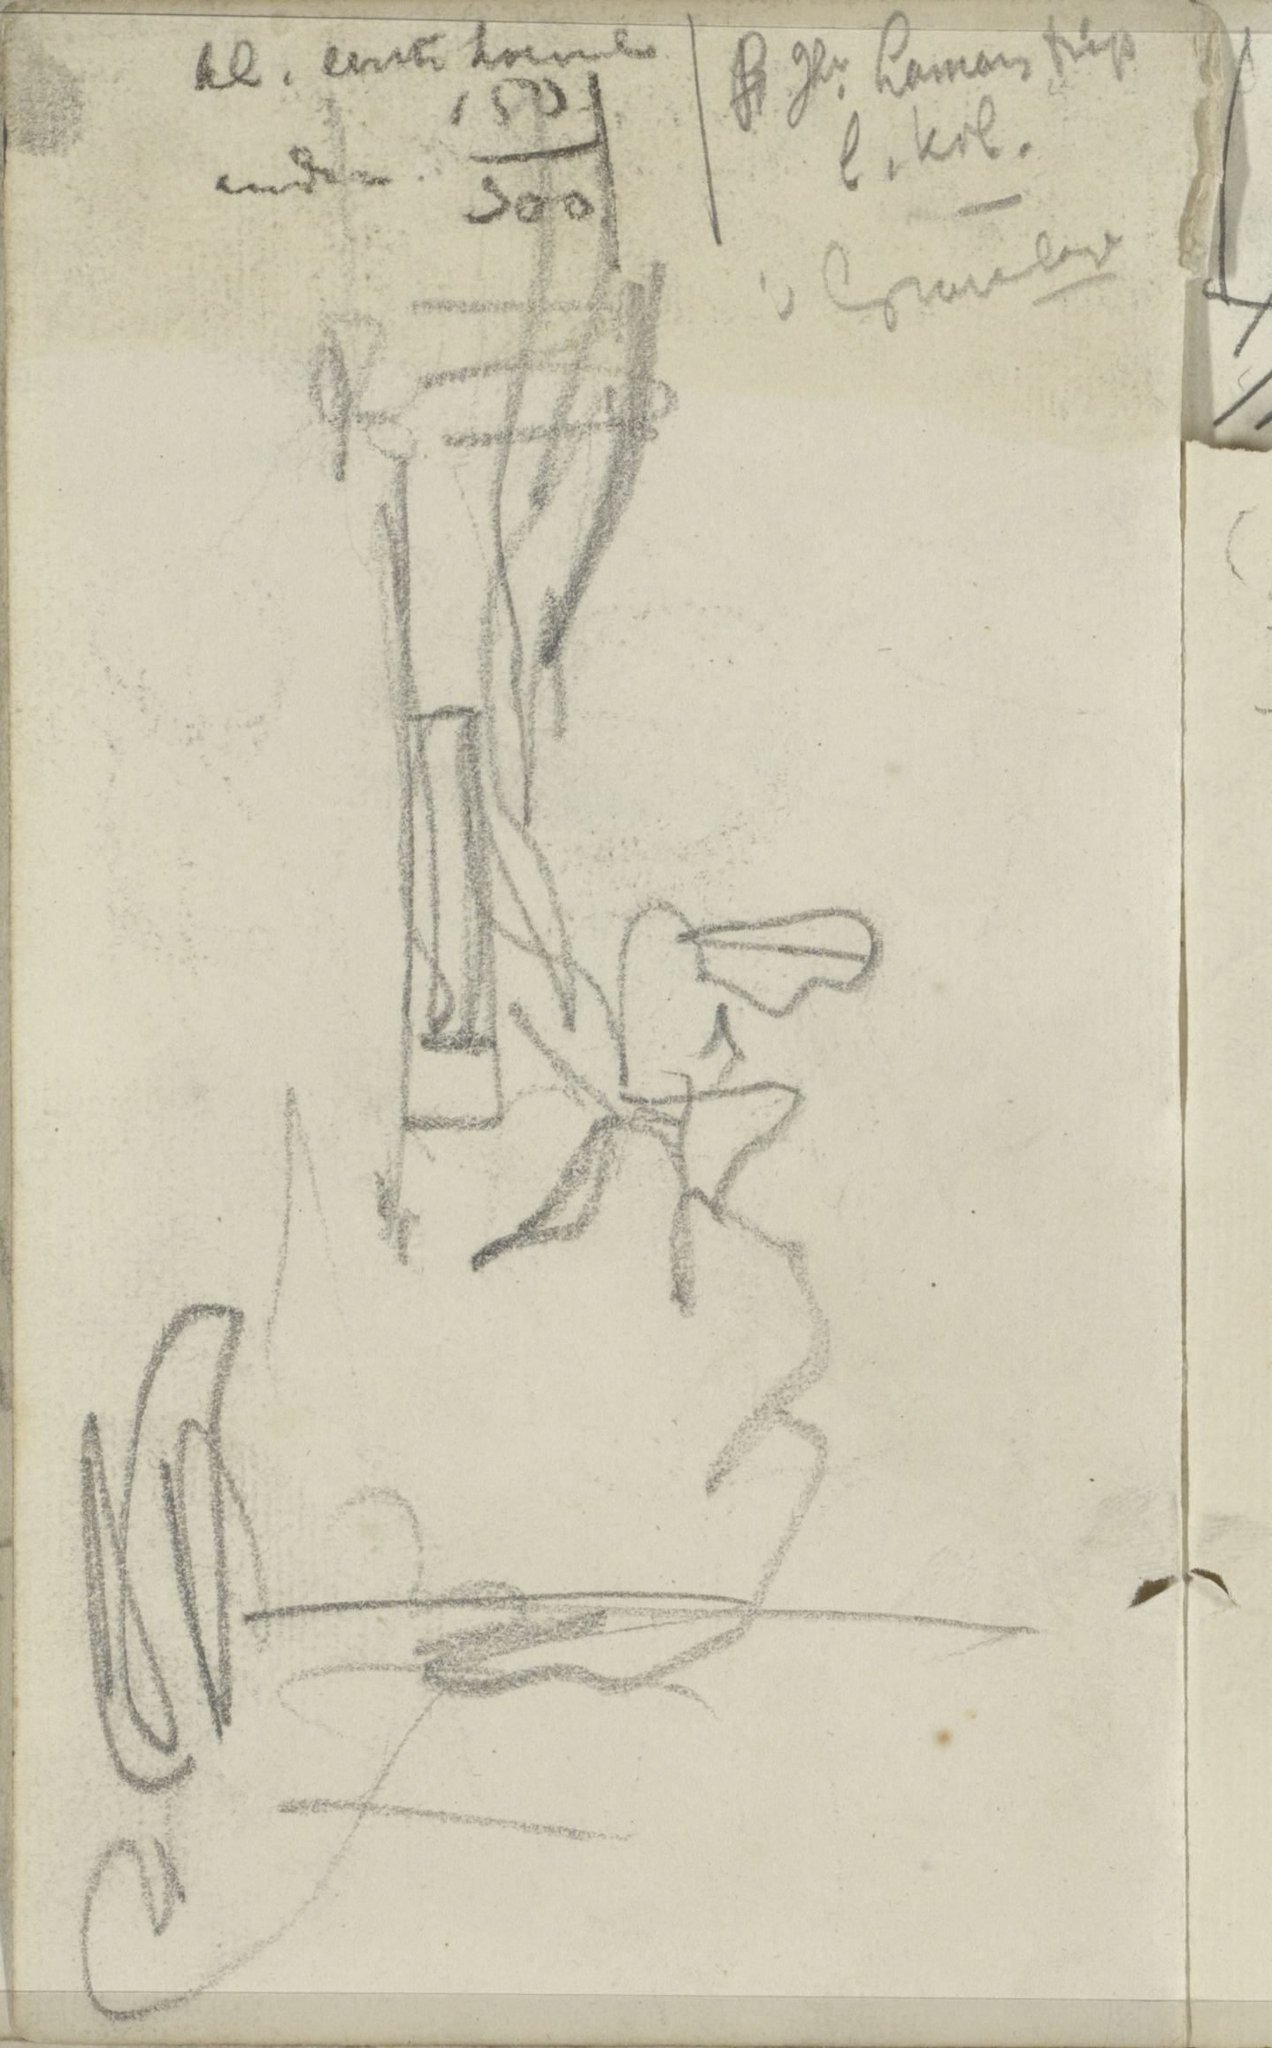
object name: sketchbook leaf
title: Landschap met een boot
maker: george hendrik breitner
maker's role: draughtsman, painter, print maker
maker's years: 1857-1923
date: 1887-1889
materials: paper, pencil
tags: landscapes, ships (in general)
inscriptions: annotation: ‘[...]’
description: Pagina 53 uit een schetsboek met 27 bladen.